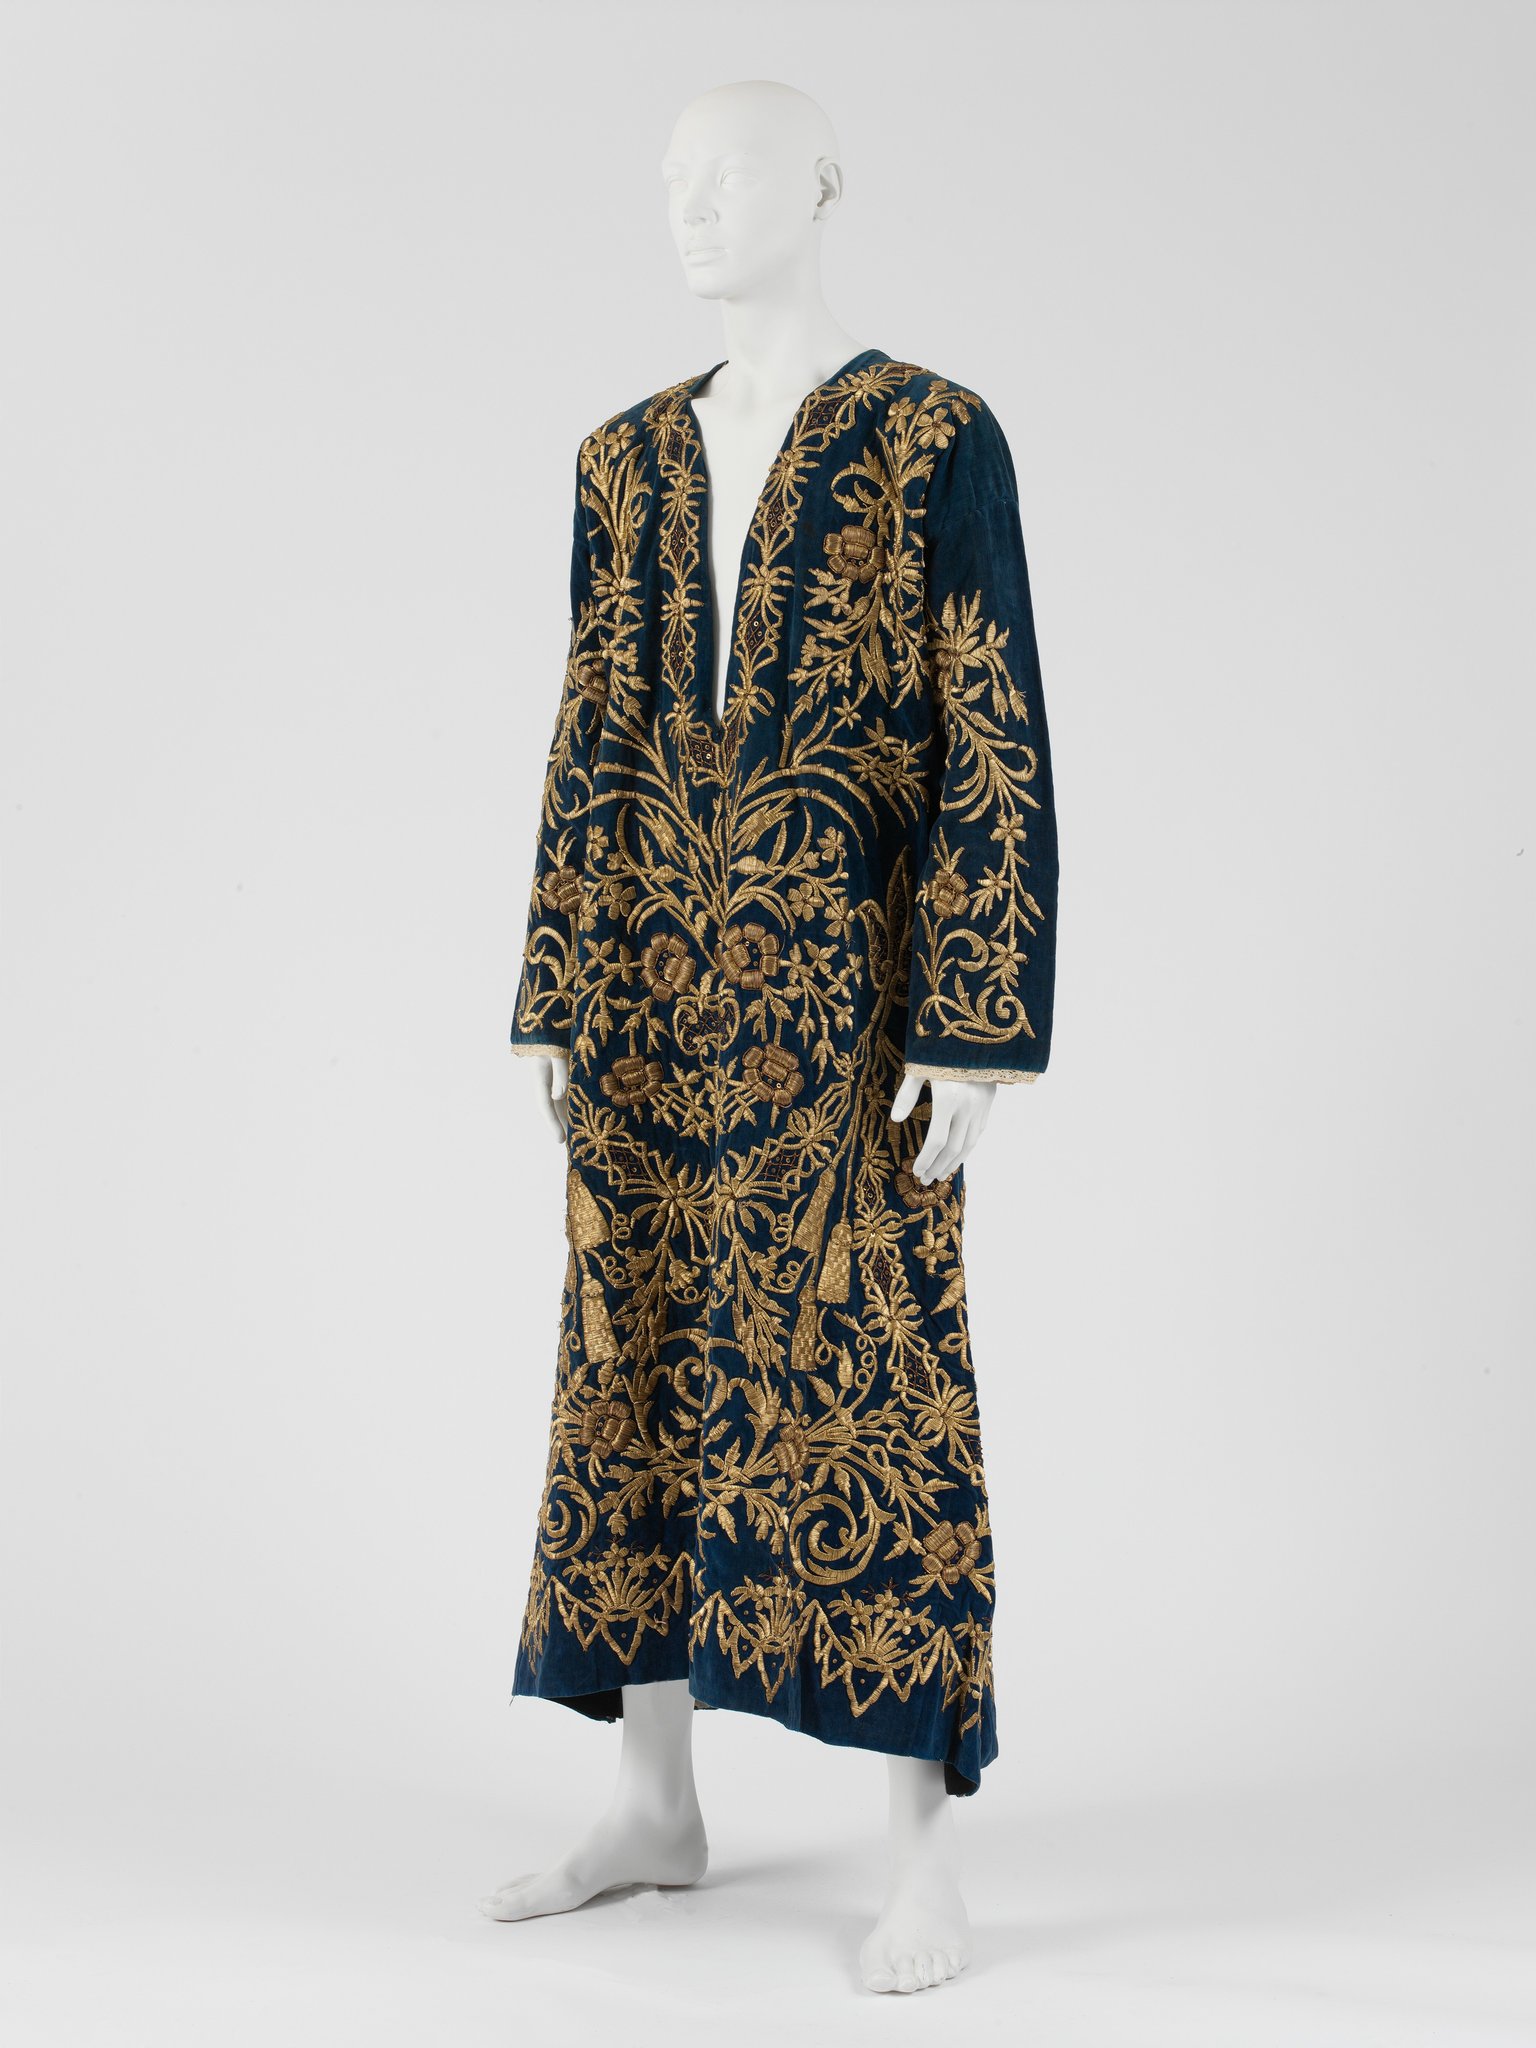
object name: dress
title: Bindalli Wedding Dress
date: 1834-1933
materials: cotton, metal thread, silk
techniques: embroidery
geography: turkey